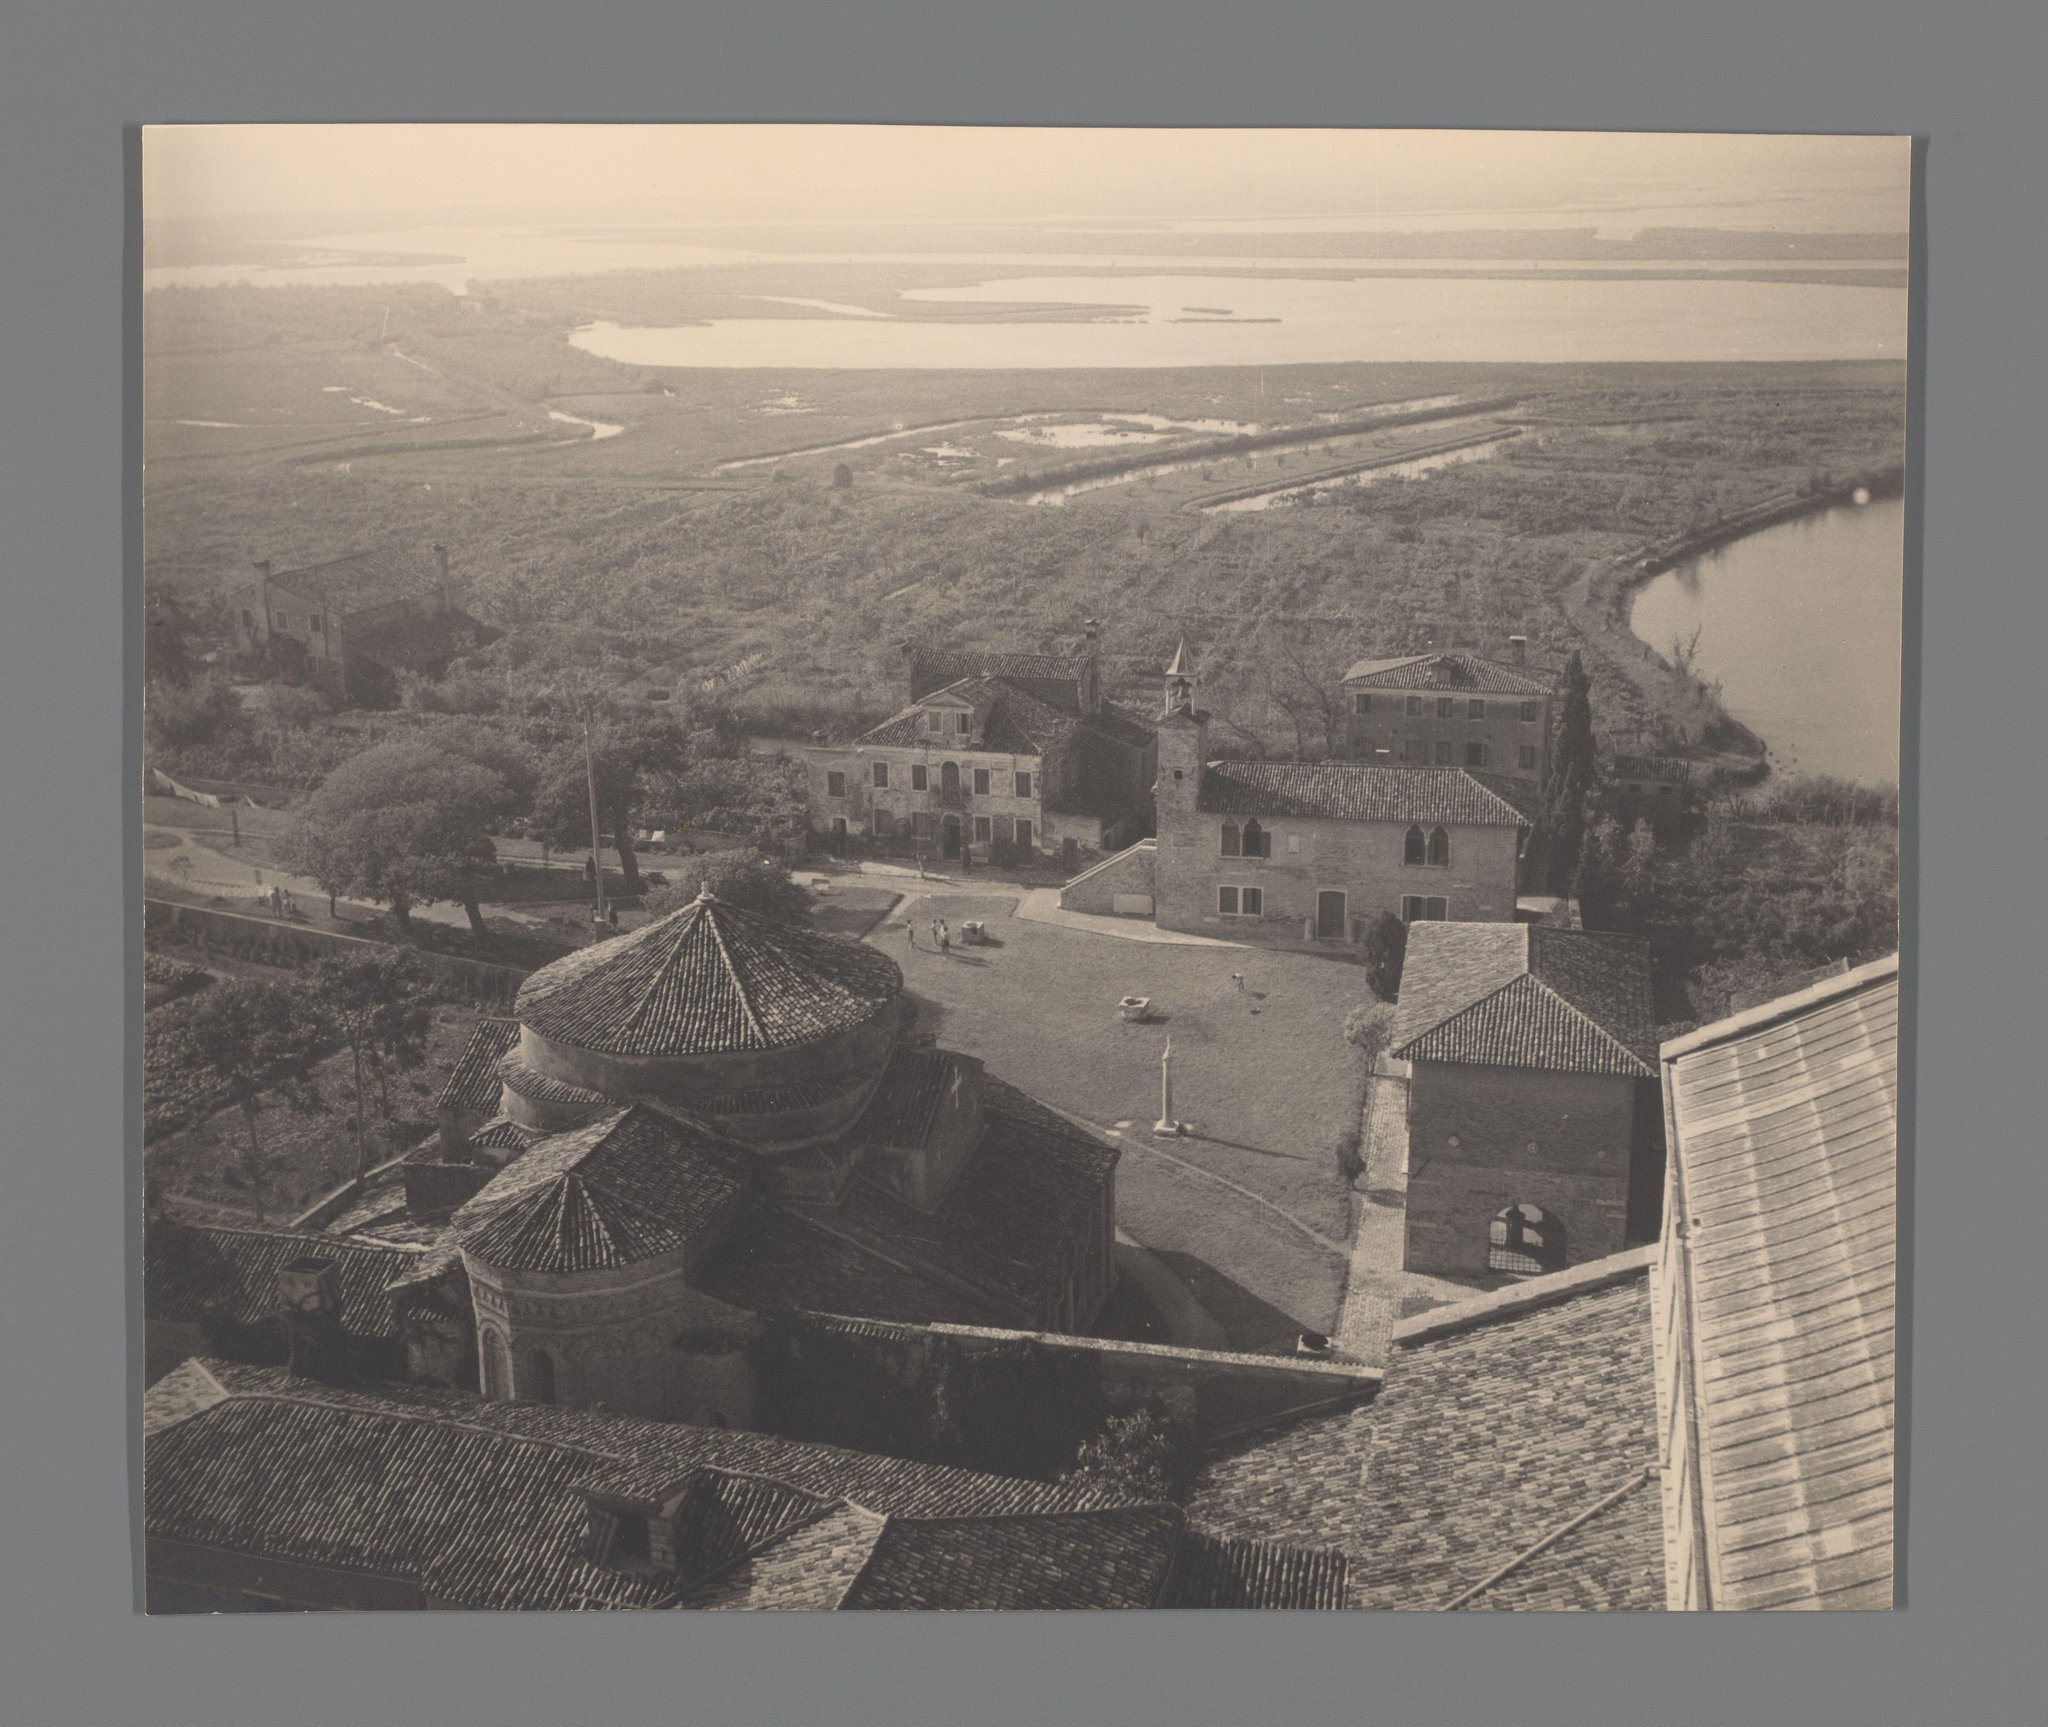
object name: photograph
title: Torcello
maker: Anonymous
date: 1885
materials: photographic support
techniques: gelatin silver print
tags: torcello